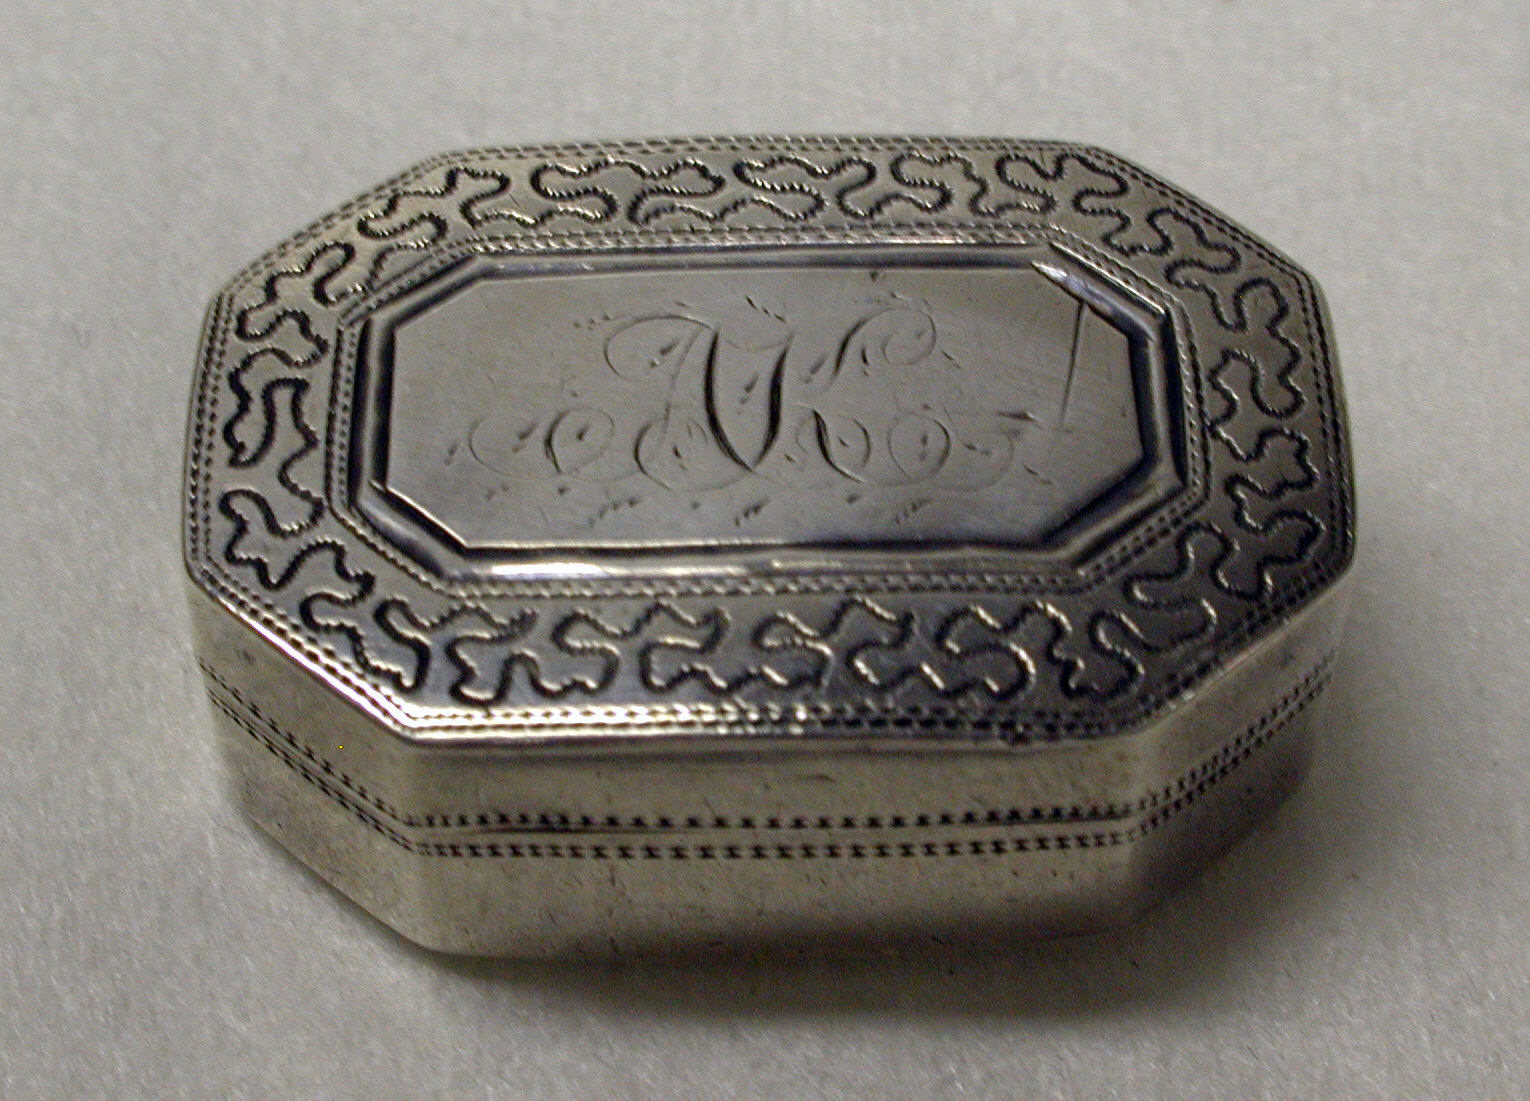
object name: vinaigrette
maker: samuel pemberton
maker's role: maker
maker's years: 1750-1850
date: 1799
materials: silver